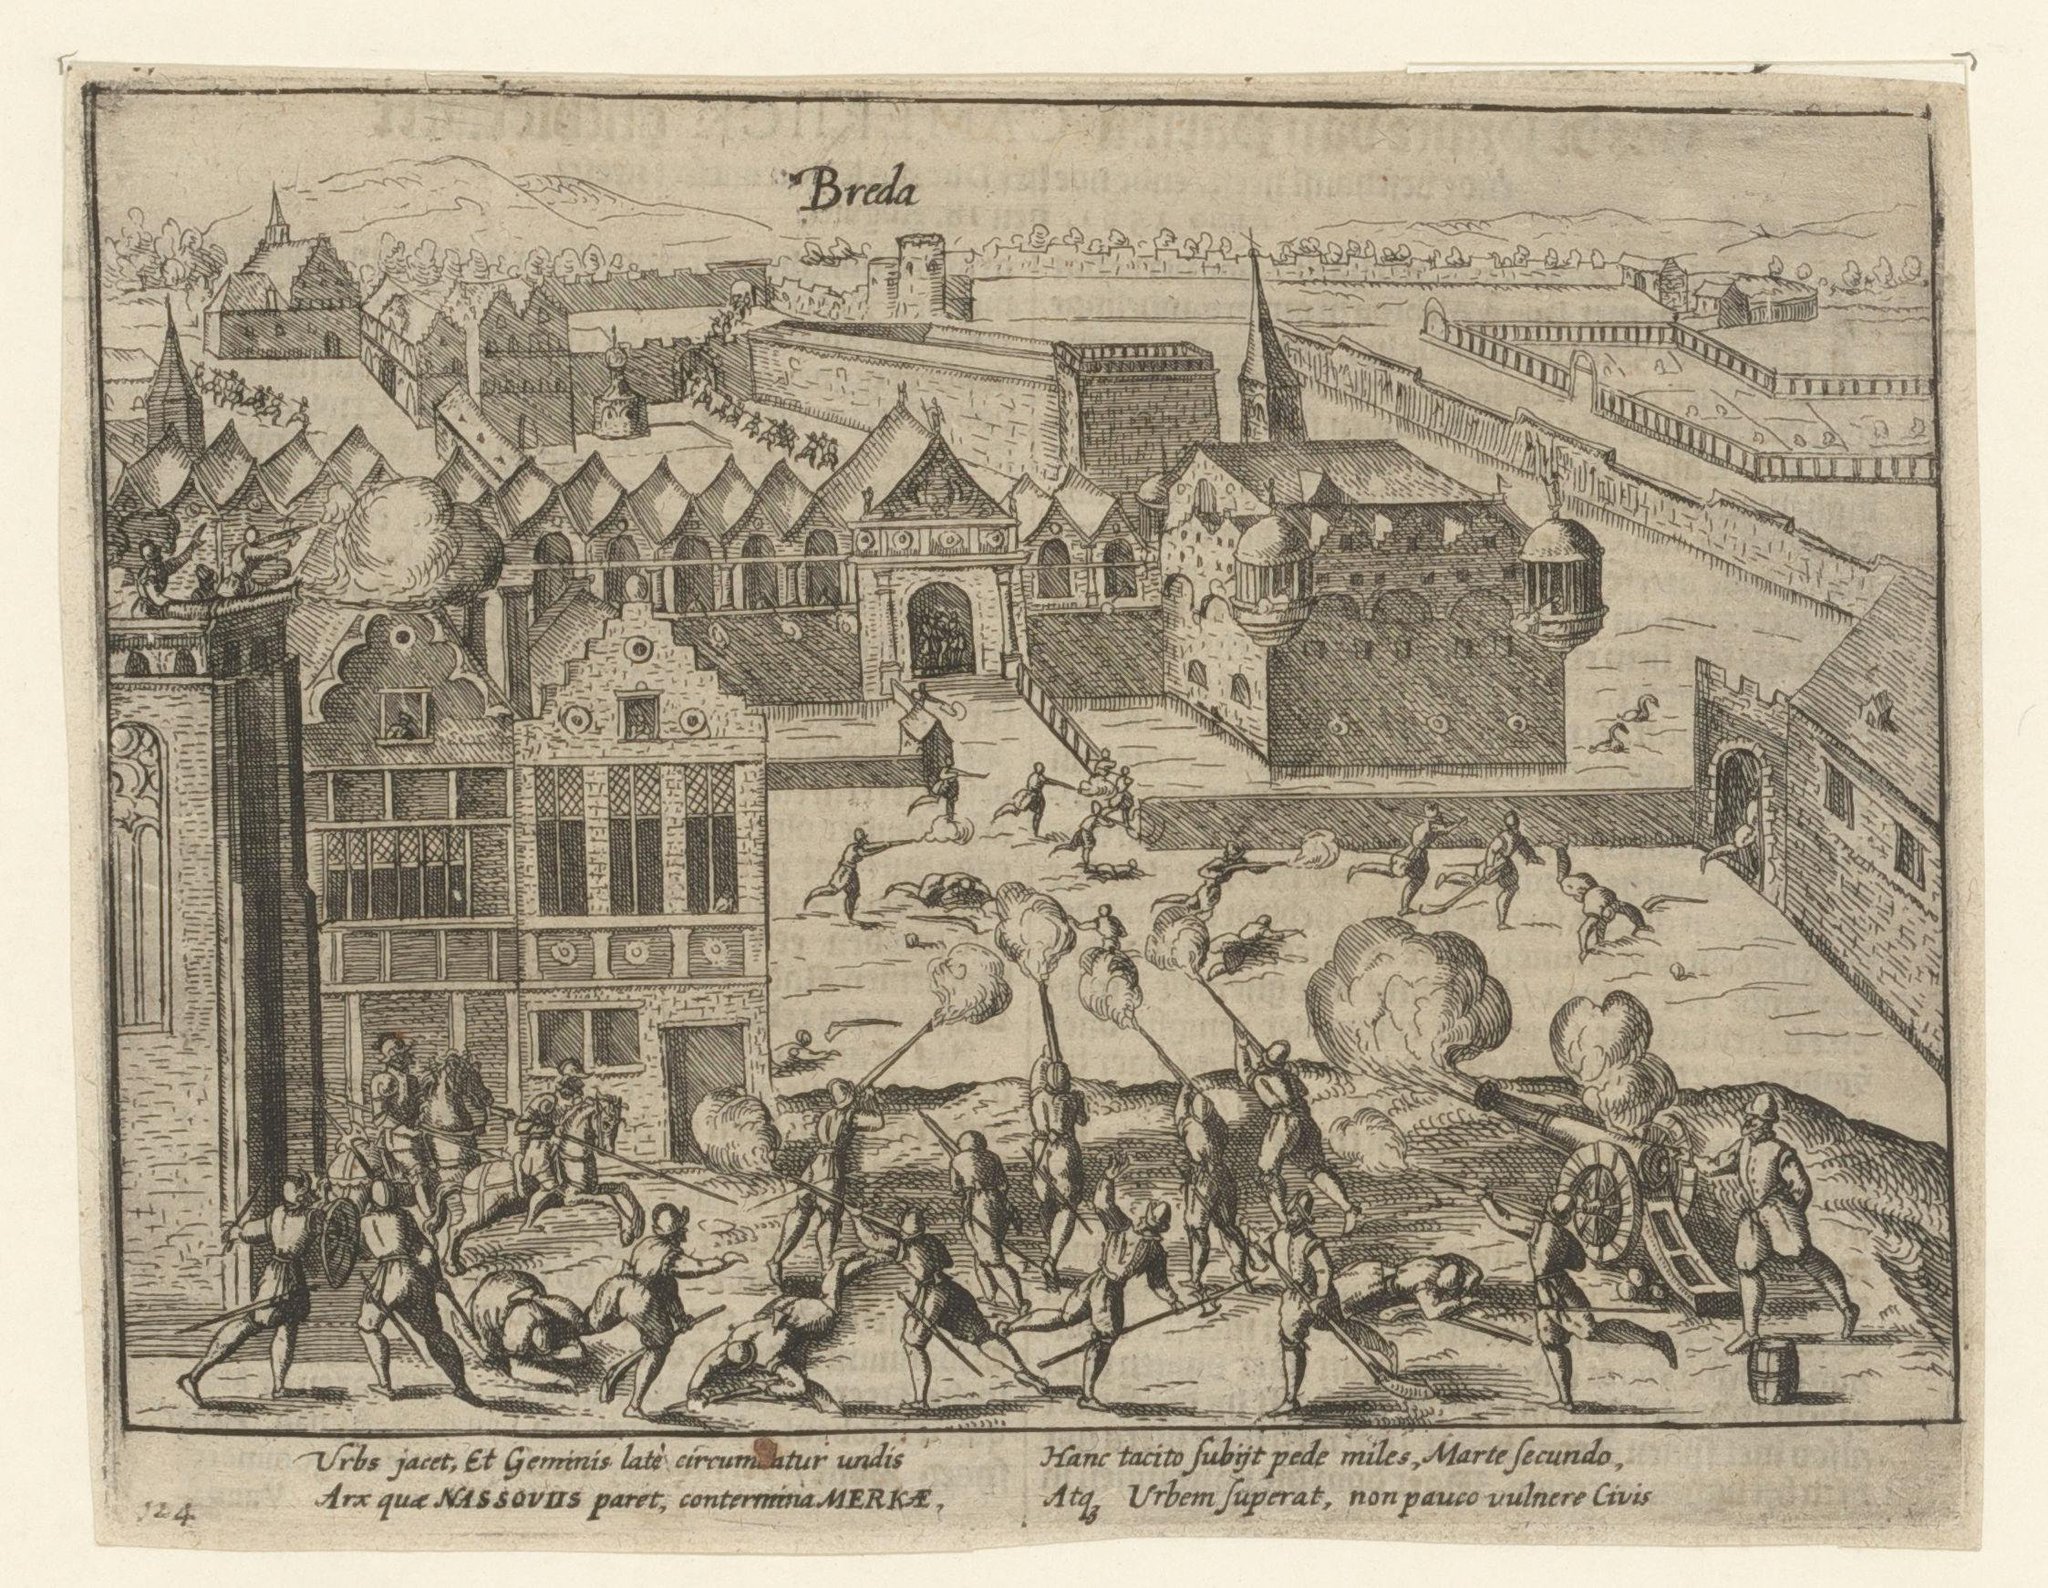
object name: book illustration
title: Verovering van Breda door de Malcontenten, 1581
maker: Anonymous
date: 1613-1615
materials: paper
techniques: etching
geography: northern netherlands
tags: capture of city (after the siege)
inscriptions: collector's mark, collector's mark: Lugt 1641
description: Verovering van Breda door de Malcontenten onder Haultepenne, 18 juni 1581. Met een list wordt het kasteel veroverd en van daaruit de rest van de stad. Op de voorgrond schermutselingen tussen de Spanjaarden en de verdedigers van de stad. Met onderschrift van 4 regels in het Latijn. Genummerd 124. Bedrukt op achterzijde met tekst in het Nederlands. Onderwerpsrubrieken binnen de Atlas Zeden en Gewoonten: Krijgswezen; prenten van Baudart. 80j. oorlog.